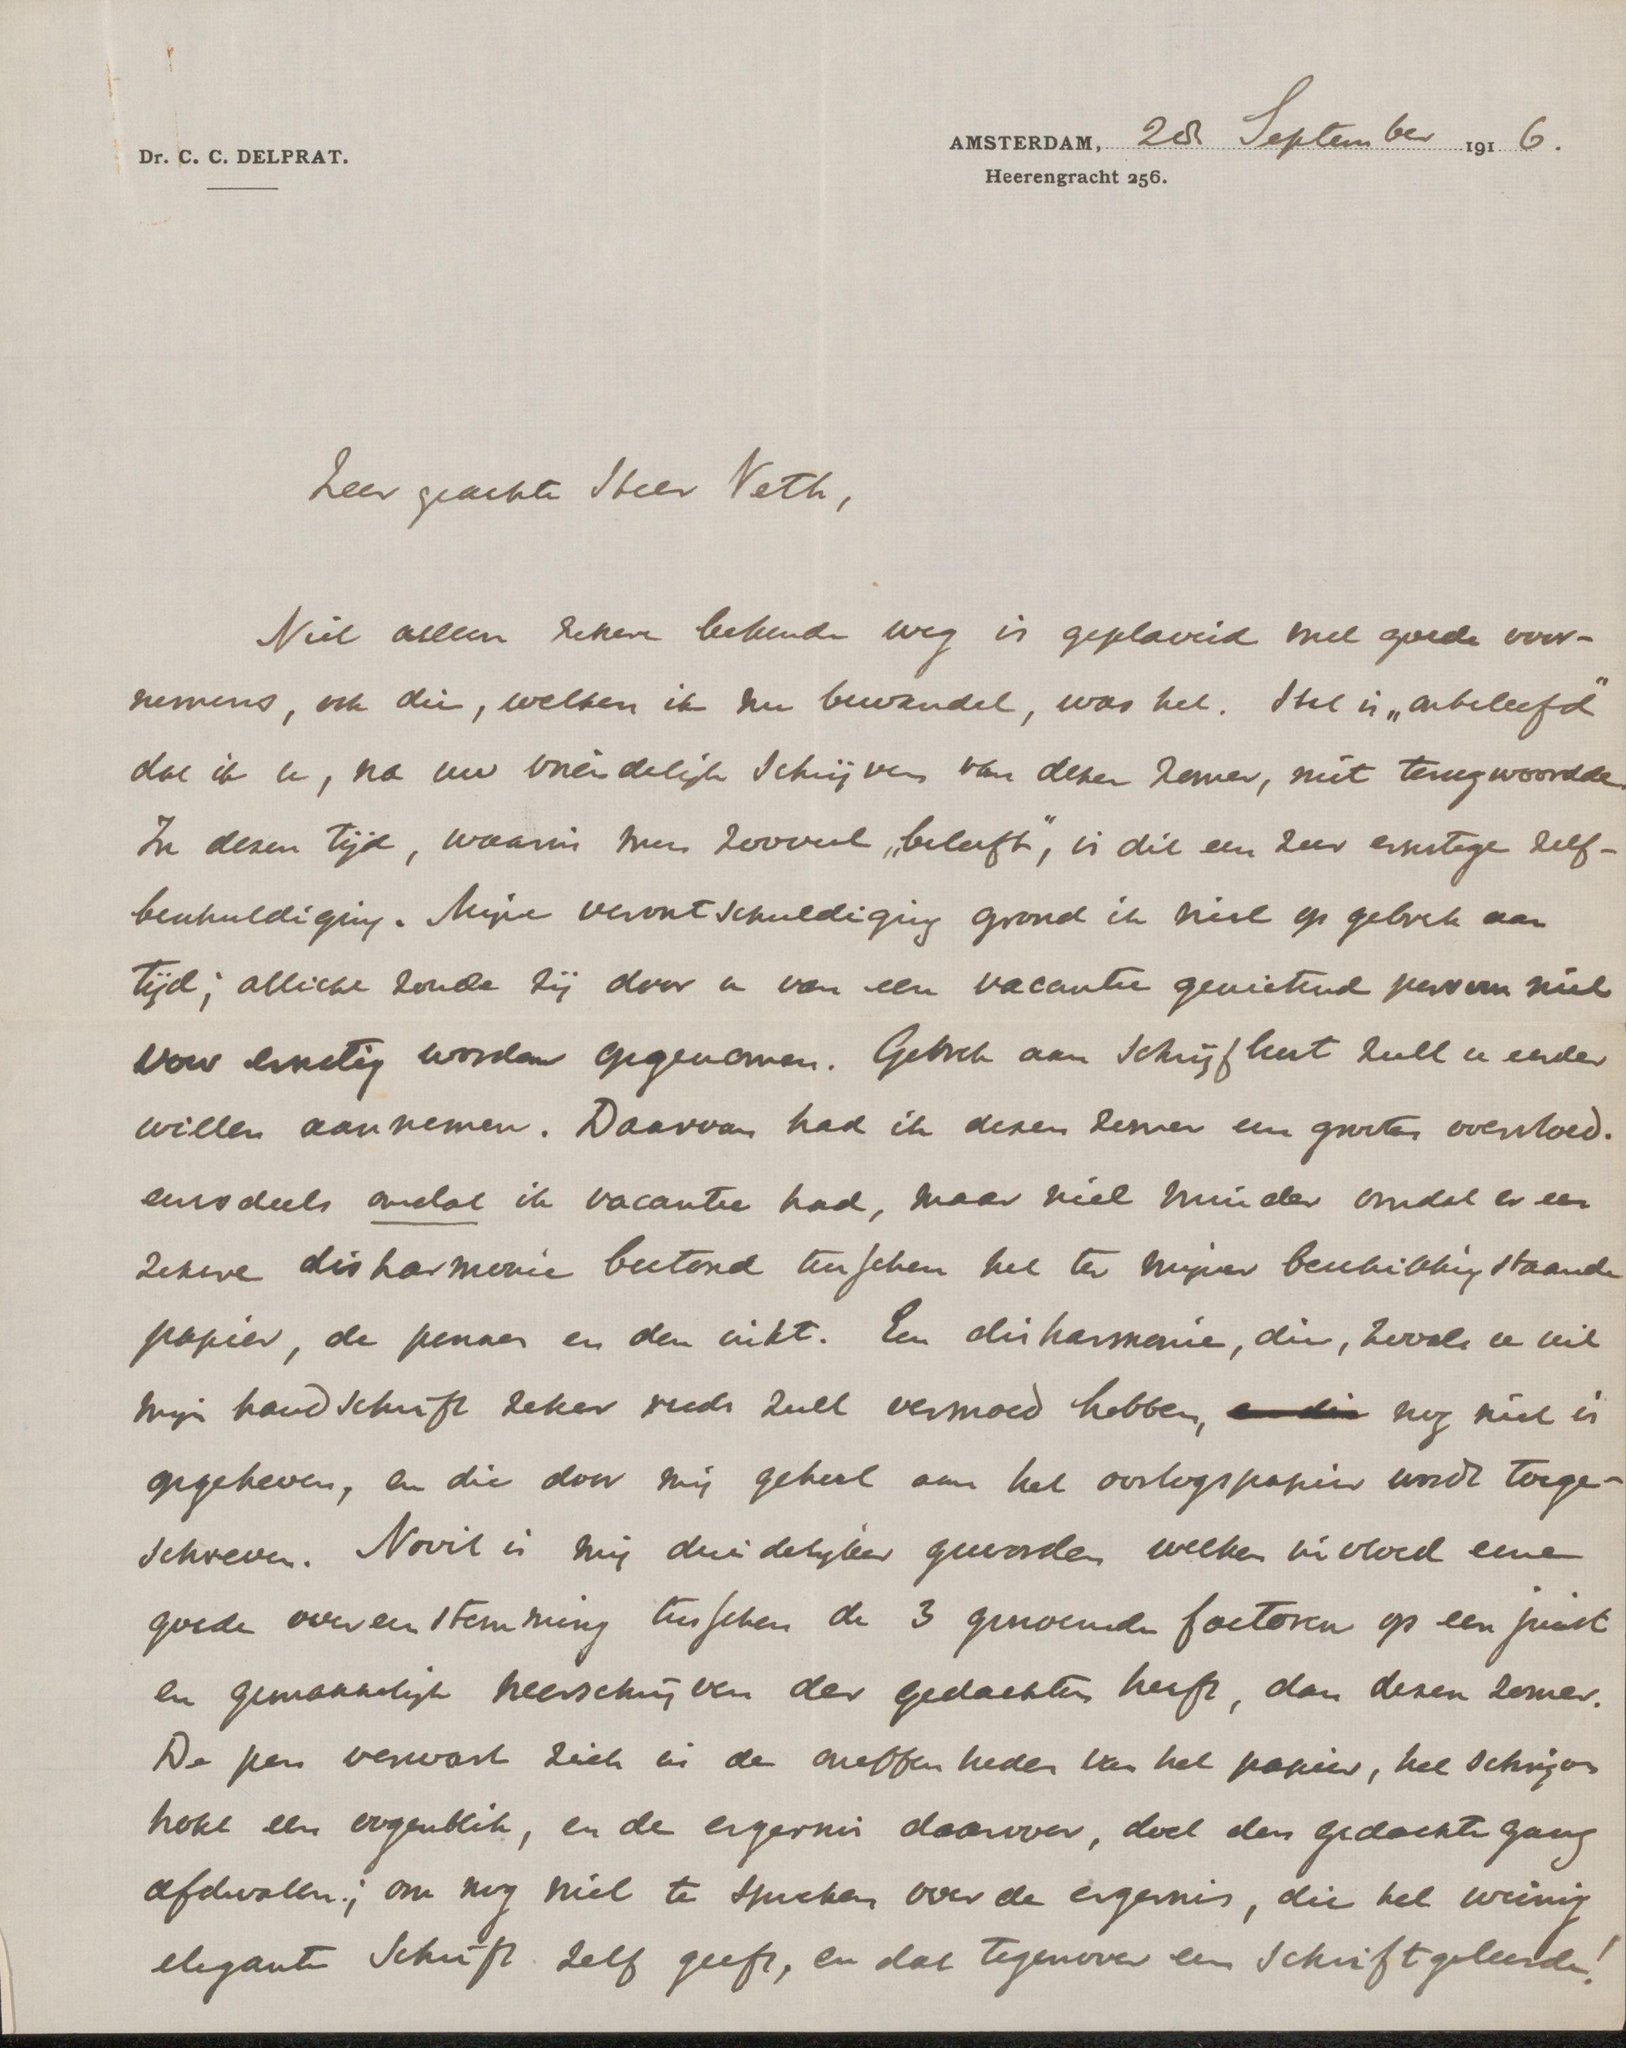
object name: letter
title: Brief aan Jan Veth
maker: c.c. delprat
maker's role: arts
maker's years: 1854-1934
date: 1916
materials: ink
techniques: pen, printing, writing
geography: amsterdam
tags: dordrecht, painter, print maker, draughtsman, designer, jan veth, family life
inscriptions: collector's mark: ‘RPK’